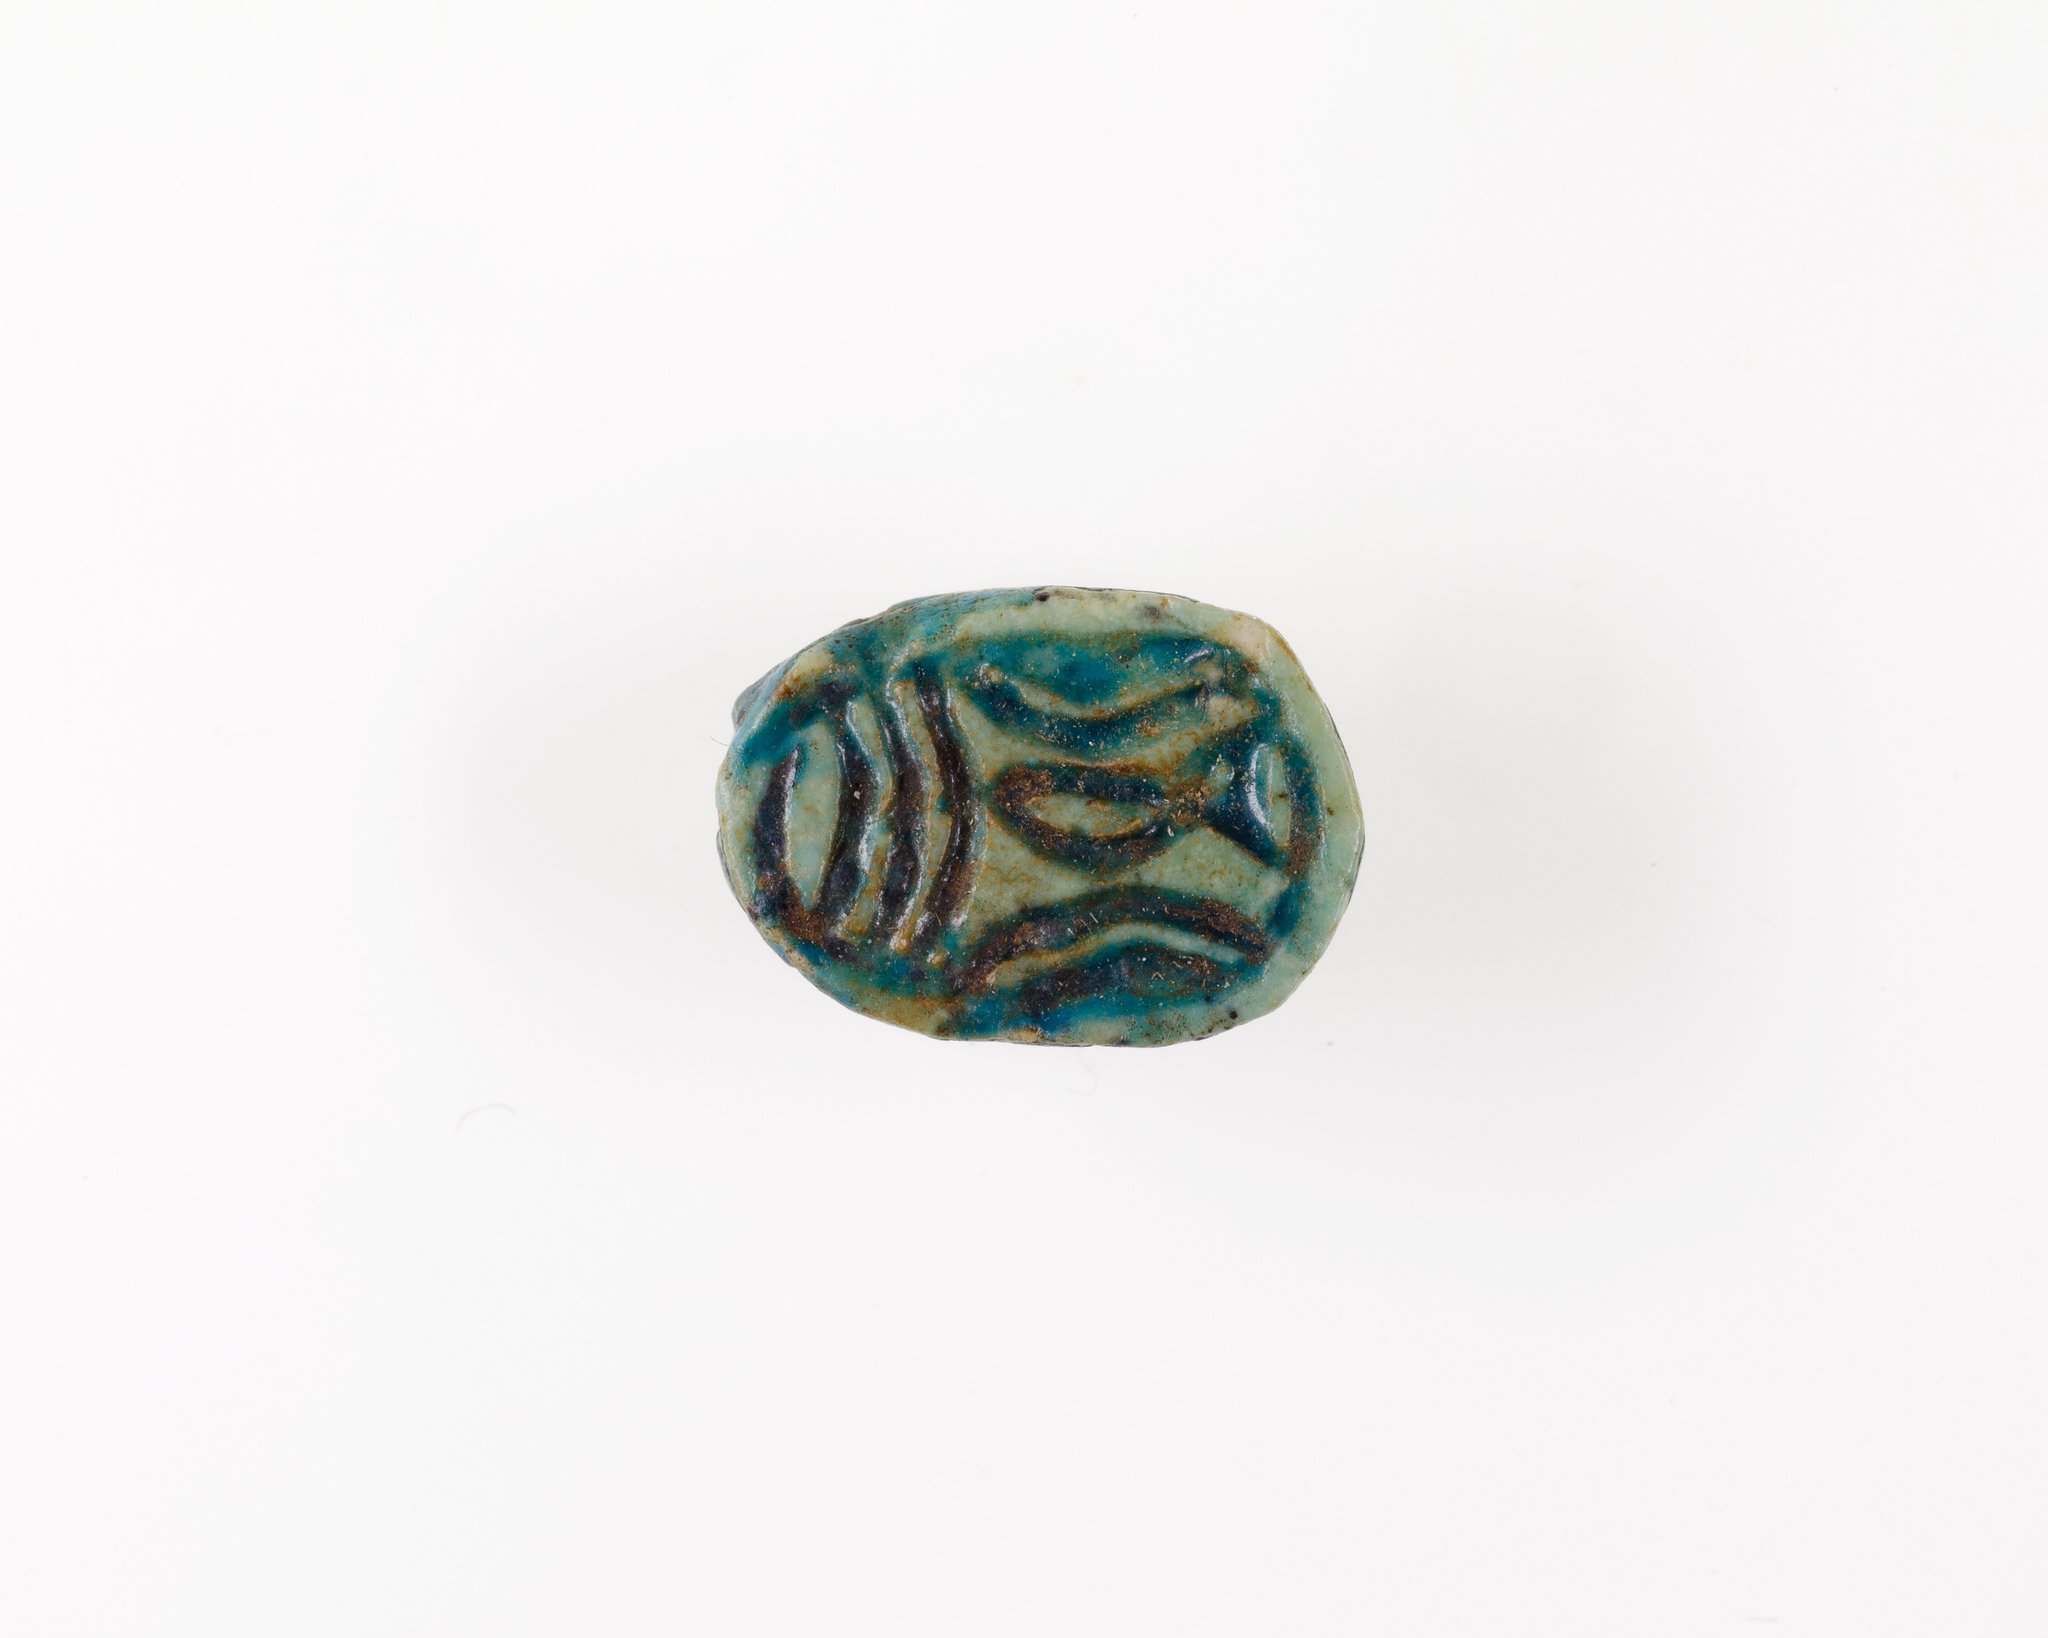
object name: scarab, sa sign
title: Scarab with Protective Sign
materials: stone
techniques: glazing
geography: egypt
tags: scarabs